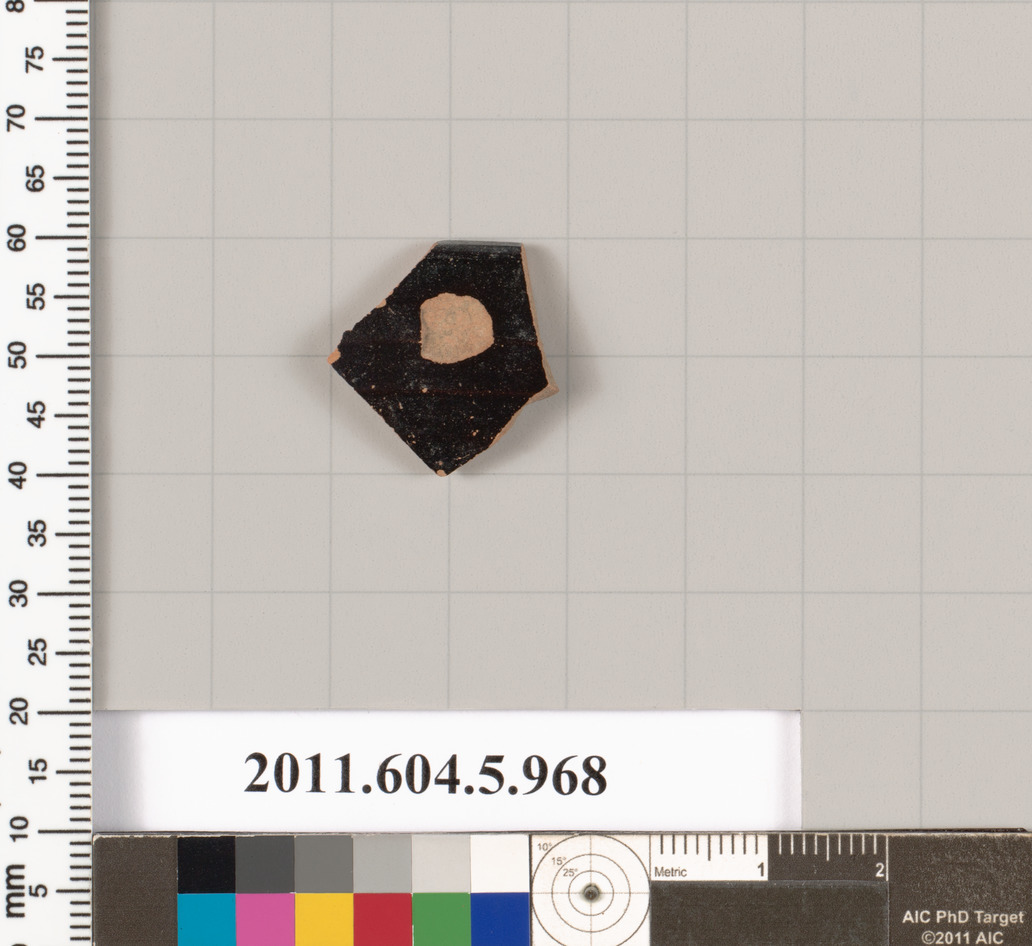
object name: kylix fragment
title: Terracotta rim fragment of a kylix (drinking cup)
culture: greek, attic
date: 500-301 BCE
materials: terracotta